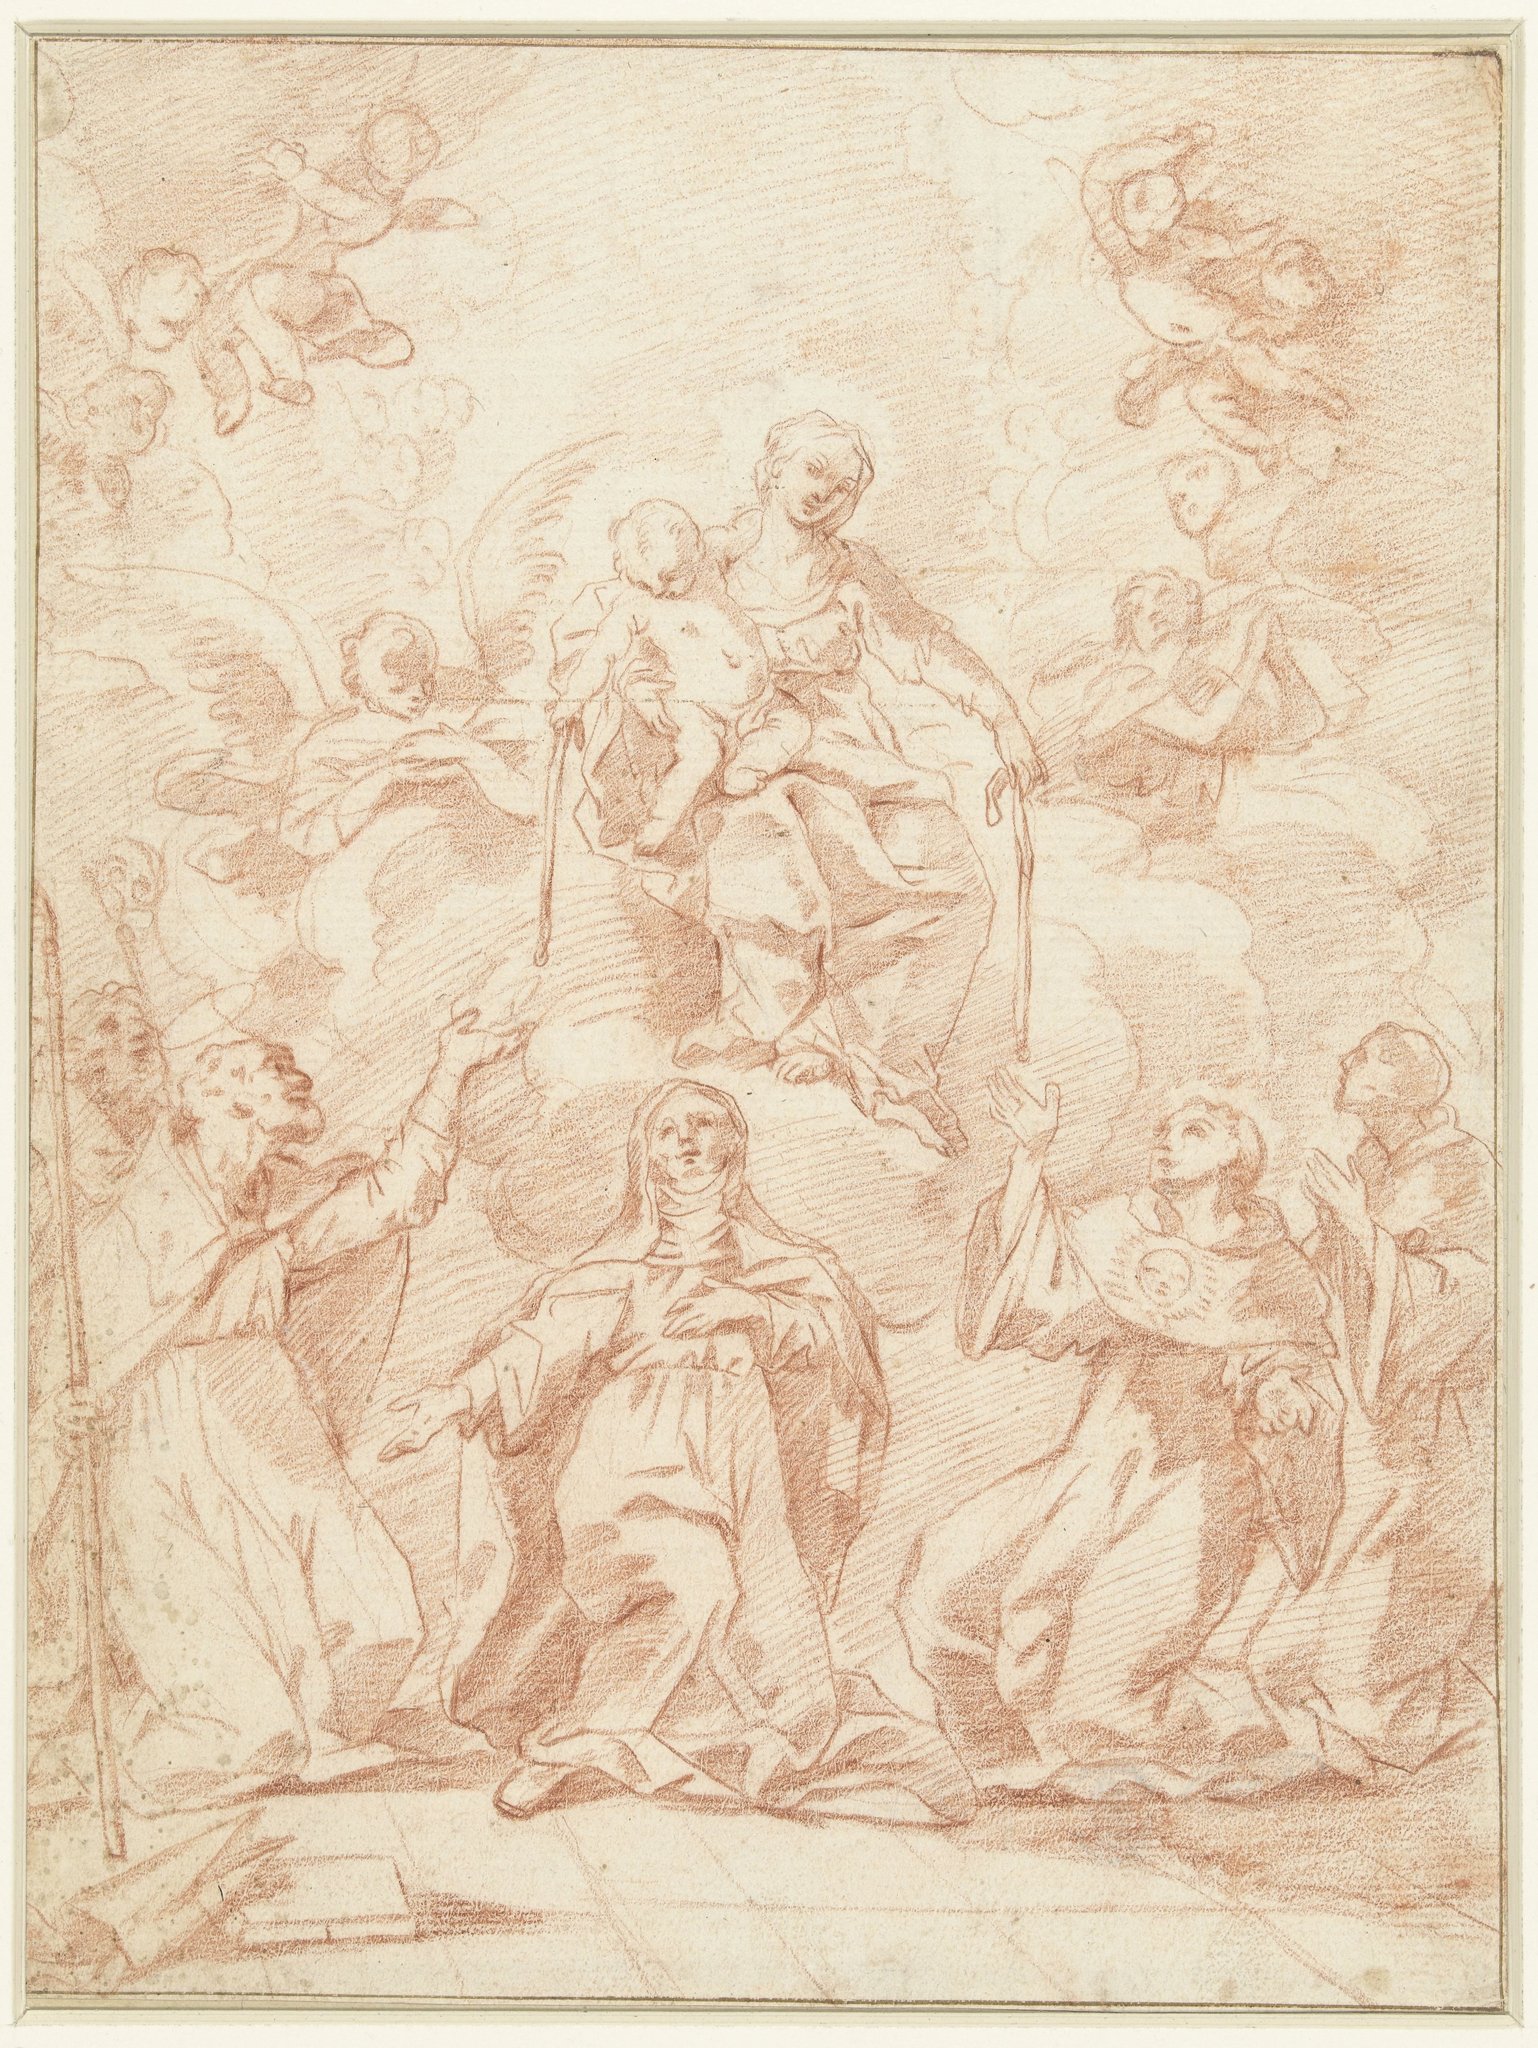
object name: drawing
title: Madonna en het kind reiken scapulieren uit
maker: francesco vanni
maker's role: draughtsman, print maker, publisher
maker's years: 1563-1610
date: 1573-1610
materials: chalk, paper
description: De Madonna en het kind, gezeten op wolken en door engelen omgeven, reiken scapulieren uit aan vijf geknielde heiligen.